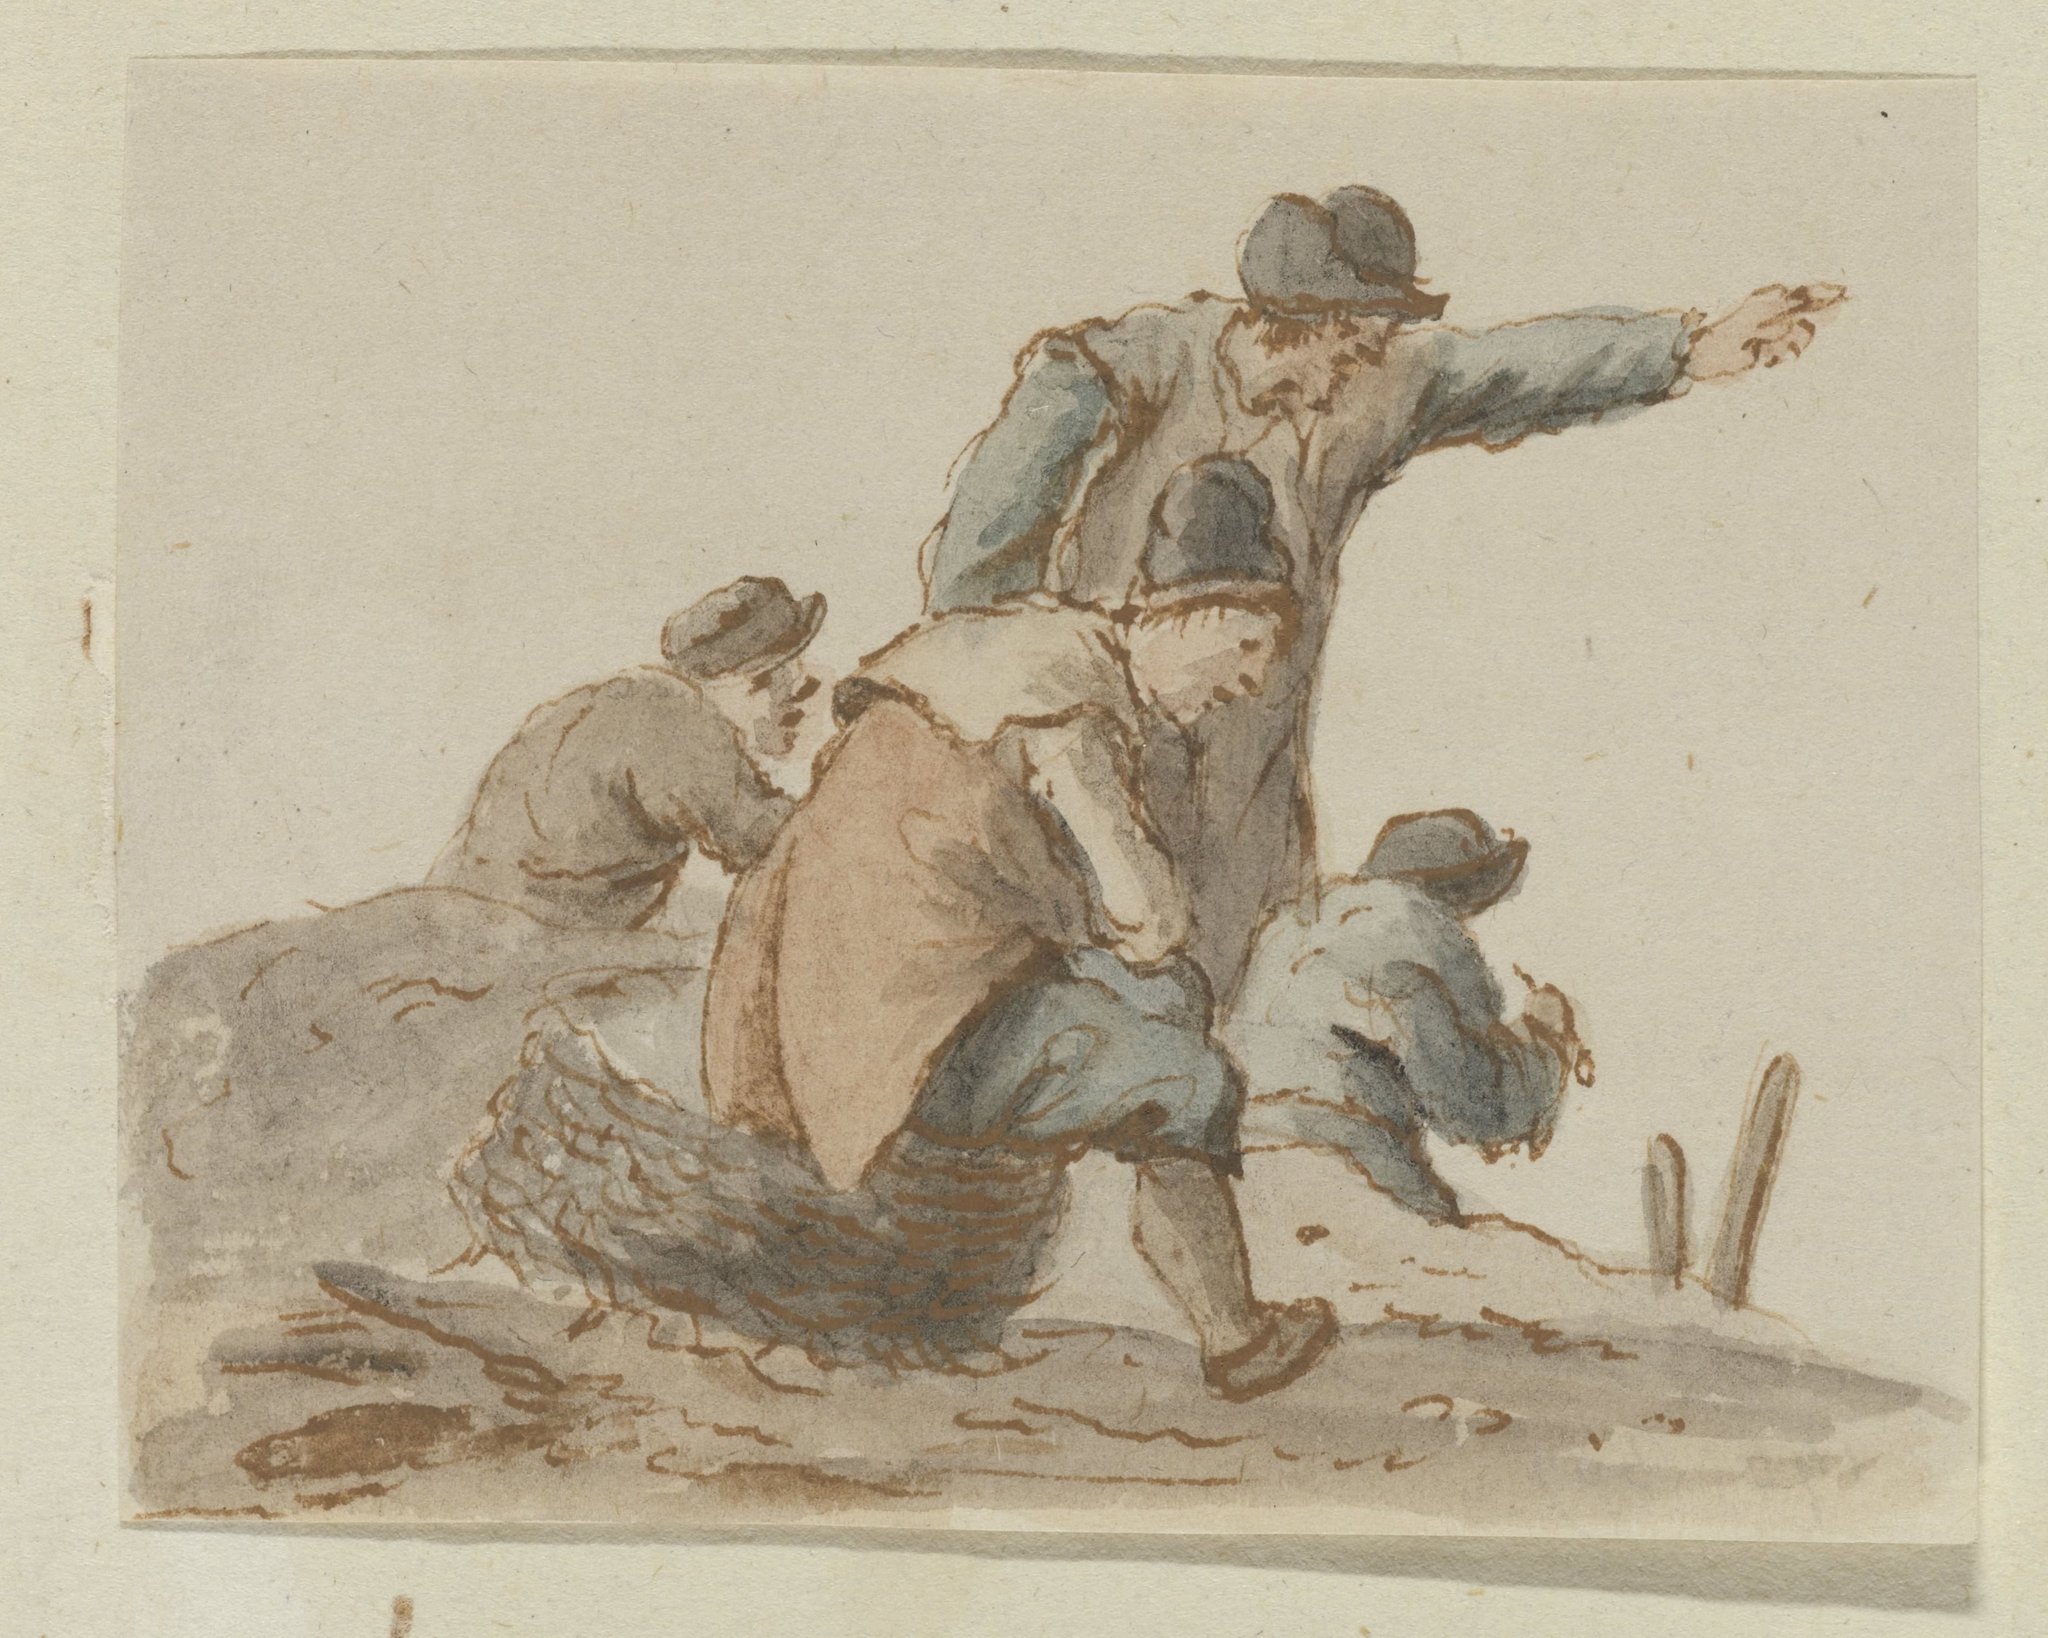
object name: drawing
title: Staande wijzende man temidden van drie zittende mannen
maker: Anonymous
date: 1700-1799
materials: ink, paper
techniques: brush, pen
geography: netherlands